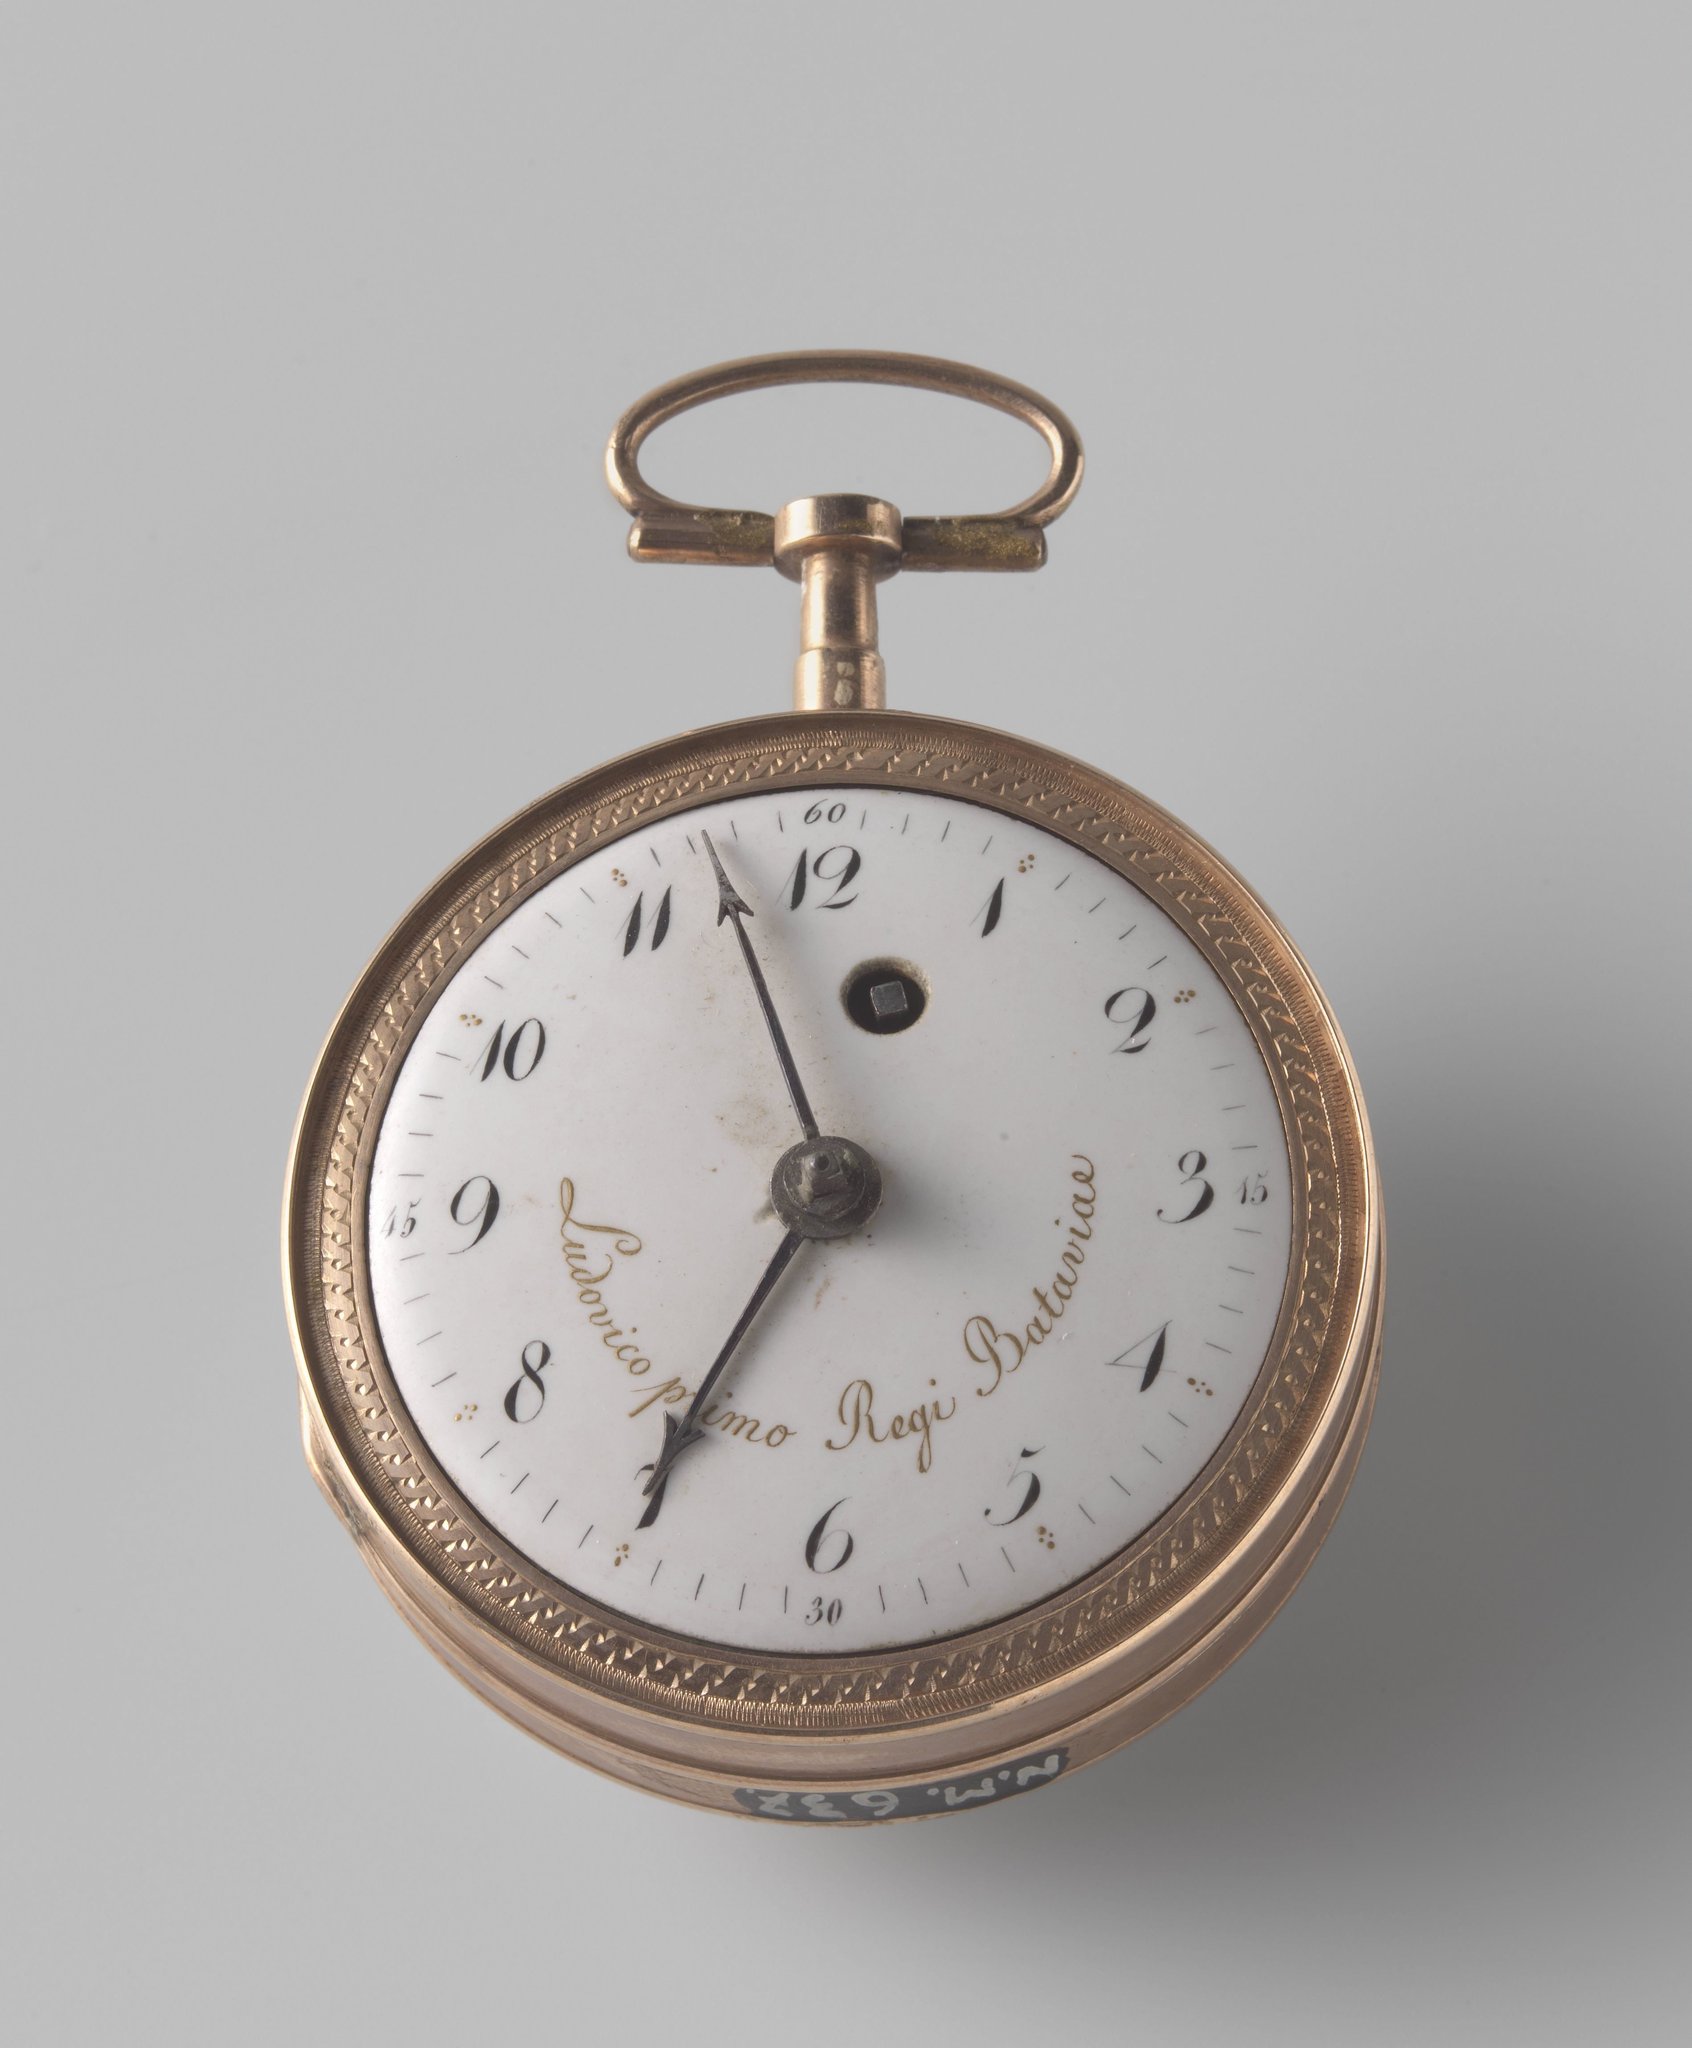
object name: pocket watch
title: Zakhorloge Lodewijk Napoleon Bonaparte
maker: Anonymous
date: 1808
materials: gold, ivory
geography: france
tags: louis napoleon (king of holland), holland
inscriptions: inscription: ‘Ludovico primo Regi Bataviae’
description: Zakhorloge. Op de wijzerplaat: Ludovics prims Regi Bataviae. Op de achterzijde de Hollandse leeuw van ivoor gesneden. Gemonteerd in goud. Het geheel binnenwerk is van ivoor. Opmerken: Opgegeven als behoord hebbende aan koning Lodewijk Napoleon.